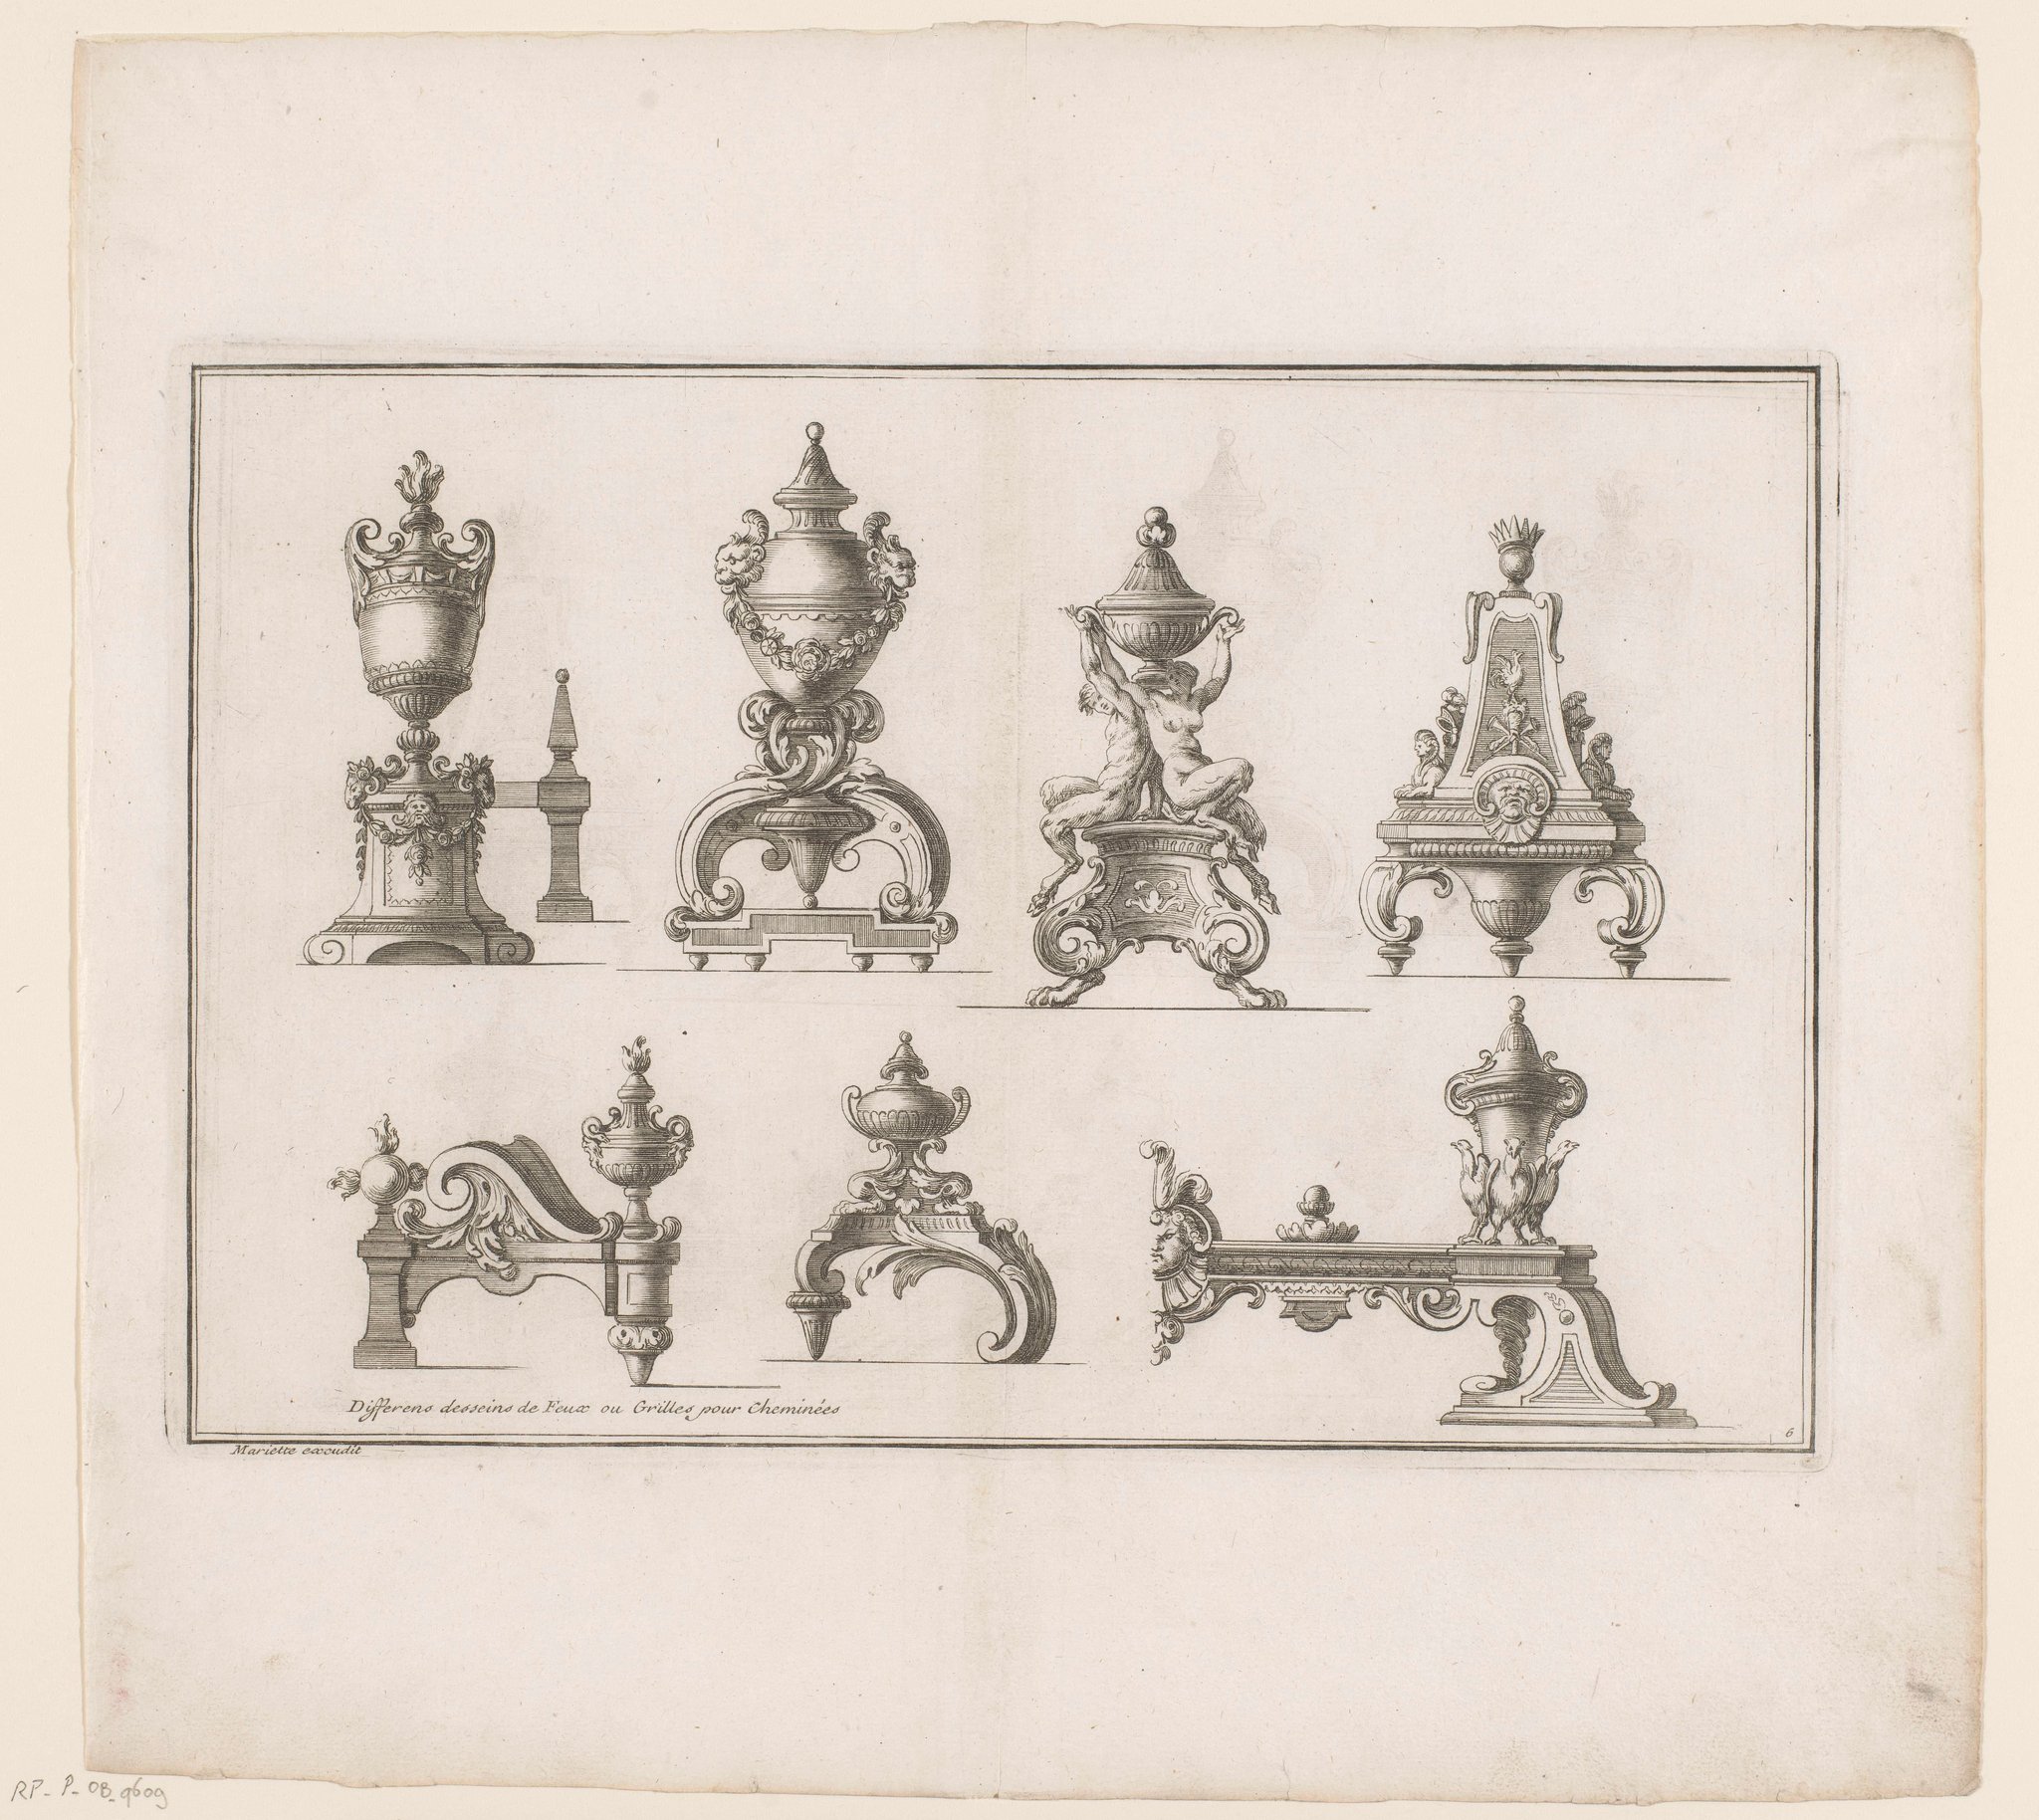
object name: ornament print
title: Differens desseins de Feux ou Grilles pour Cheminées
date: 1710-1720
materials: paper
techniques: etching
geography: paris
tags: andiron, fire-dog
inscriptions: collector's mark: Lugt 2228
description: Zeven vuurbokken met vazen, saters, sfinxen, een kroon en vogels.